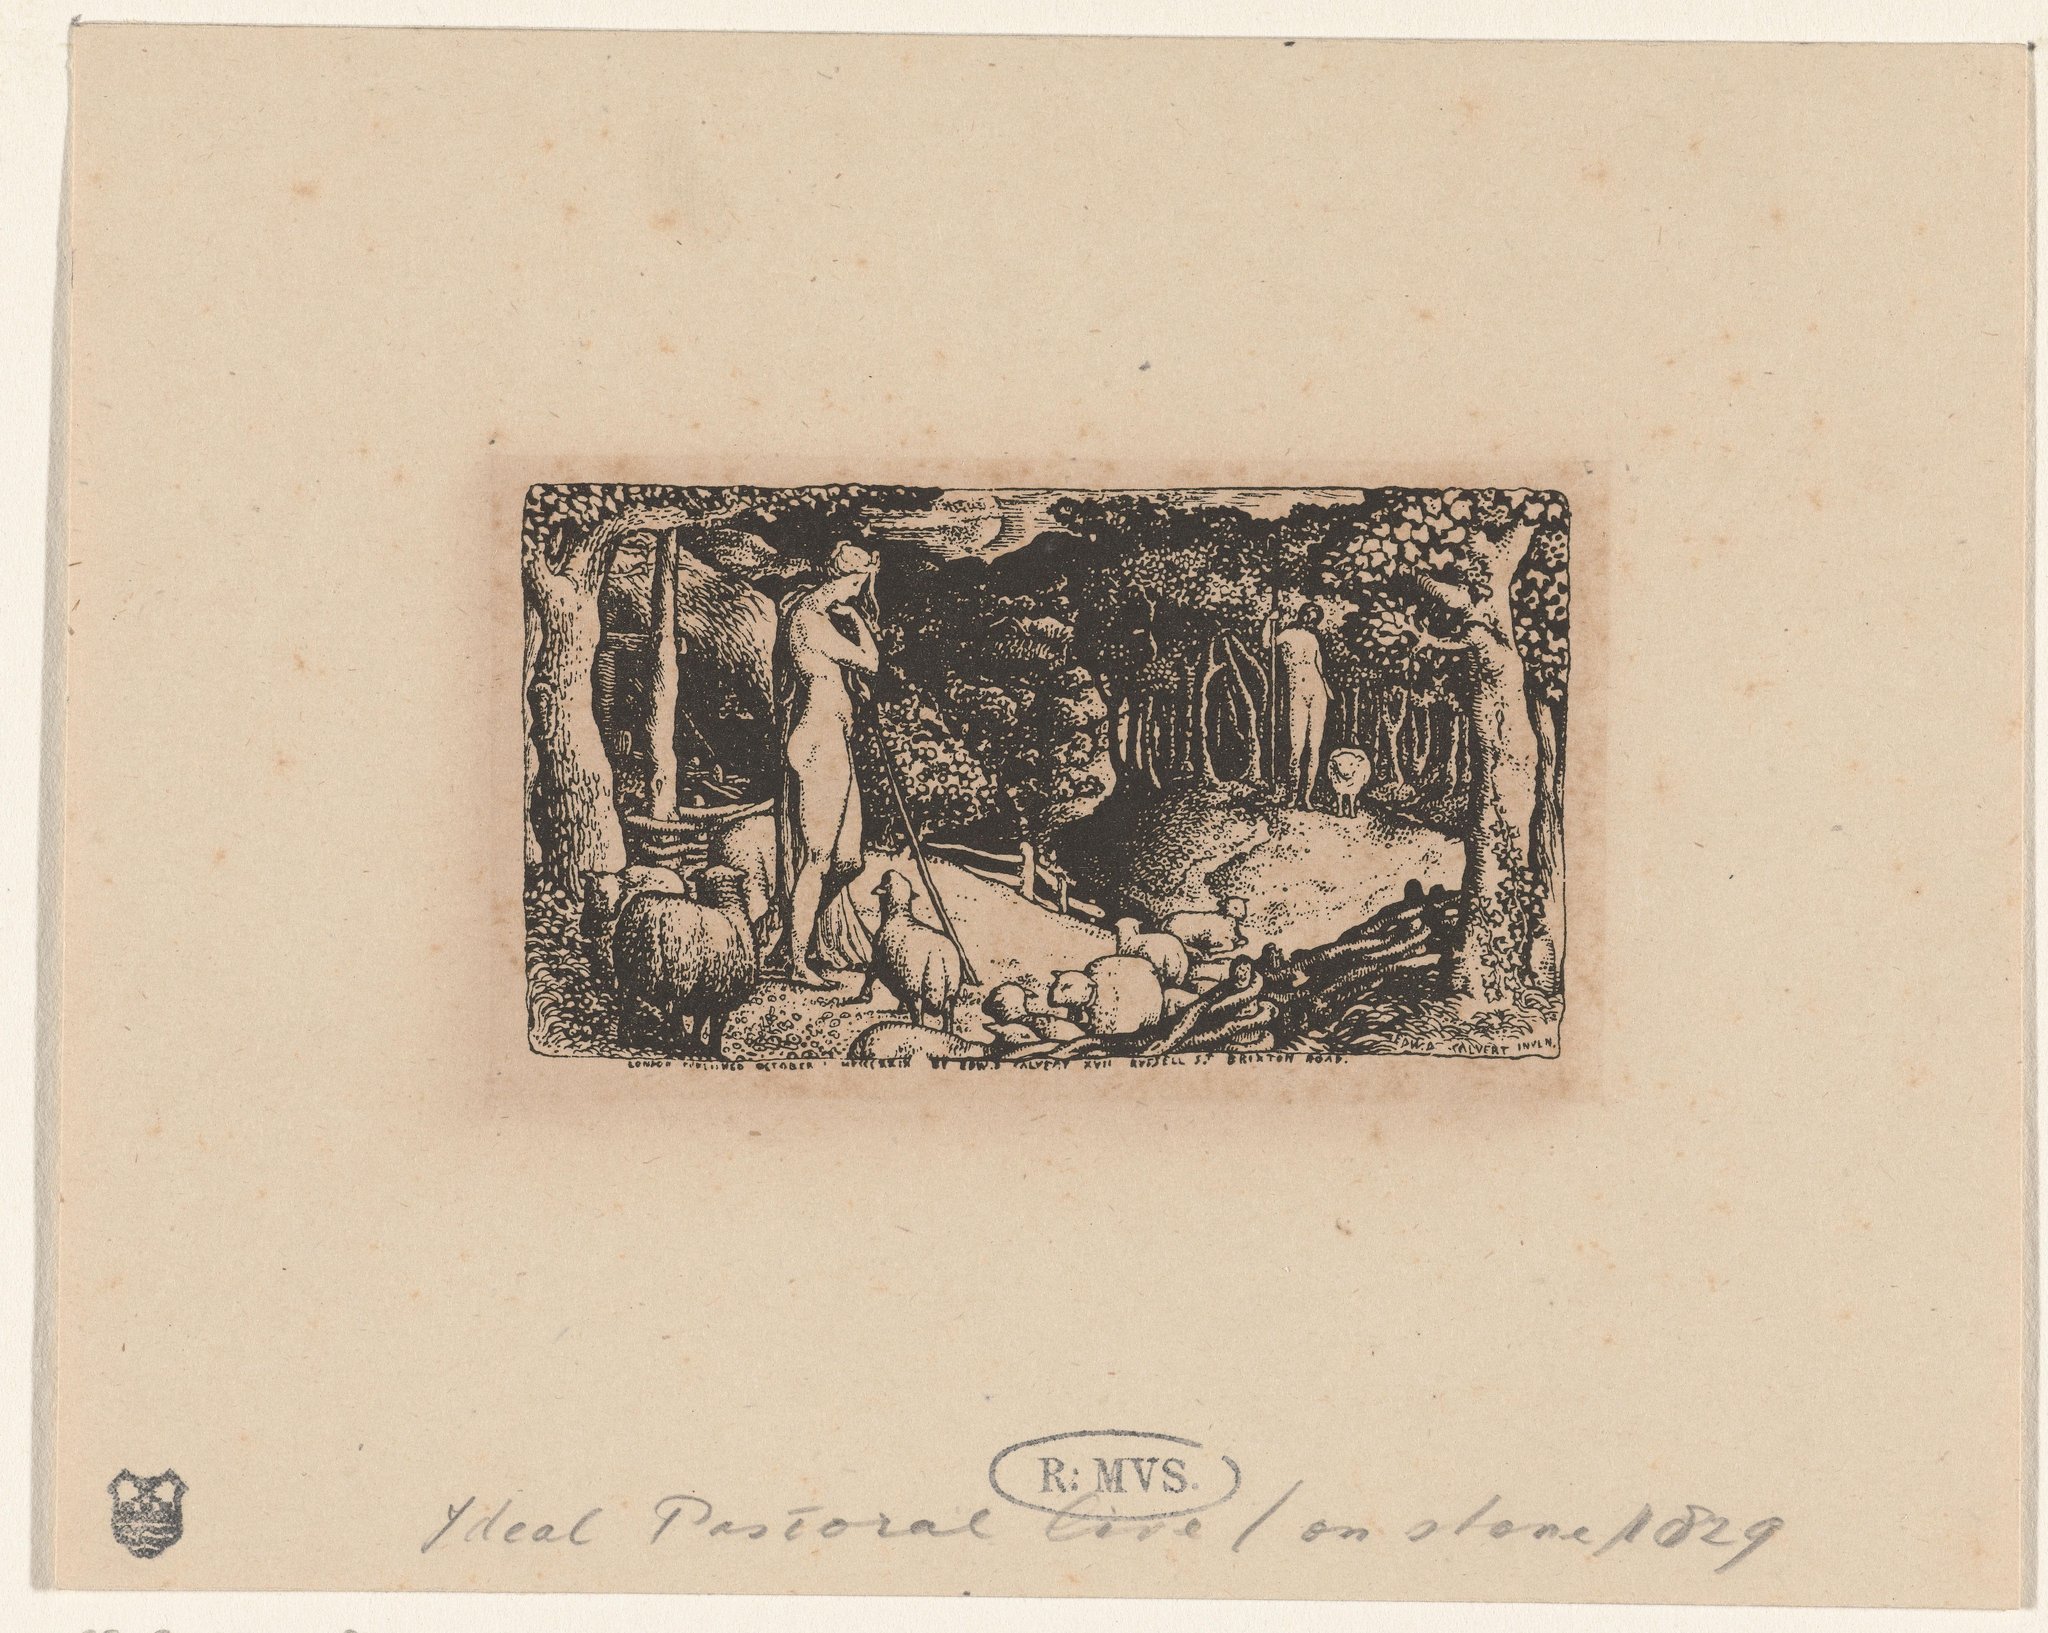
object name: print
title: Het landelijke leven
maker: edward calvert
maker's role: print maker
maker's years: 1799-1883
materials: paper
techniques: lithograph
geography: london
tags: herding, herdsman, herdswoman, shepherd, shepherdess, cowherd, etc., herd, flock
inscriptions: collector's mark: Lugt 2760, collector's mark: Lugt 2228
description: Uit het boek: S. Calvert, A Memoir of Edward Calvert artist bij his third son, uitgegeven 1893 te Londen. Botke, K.